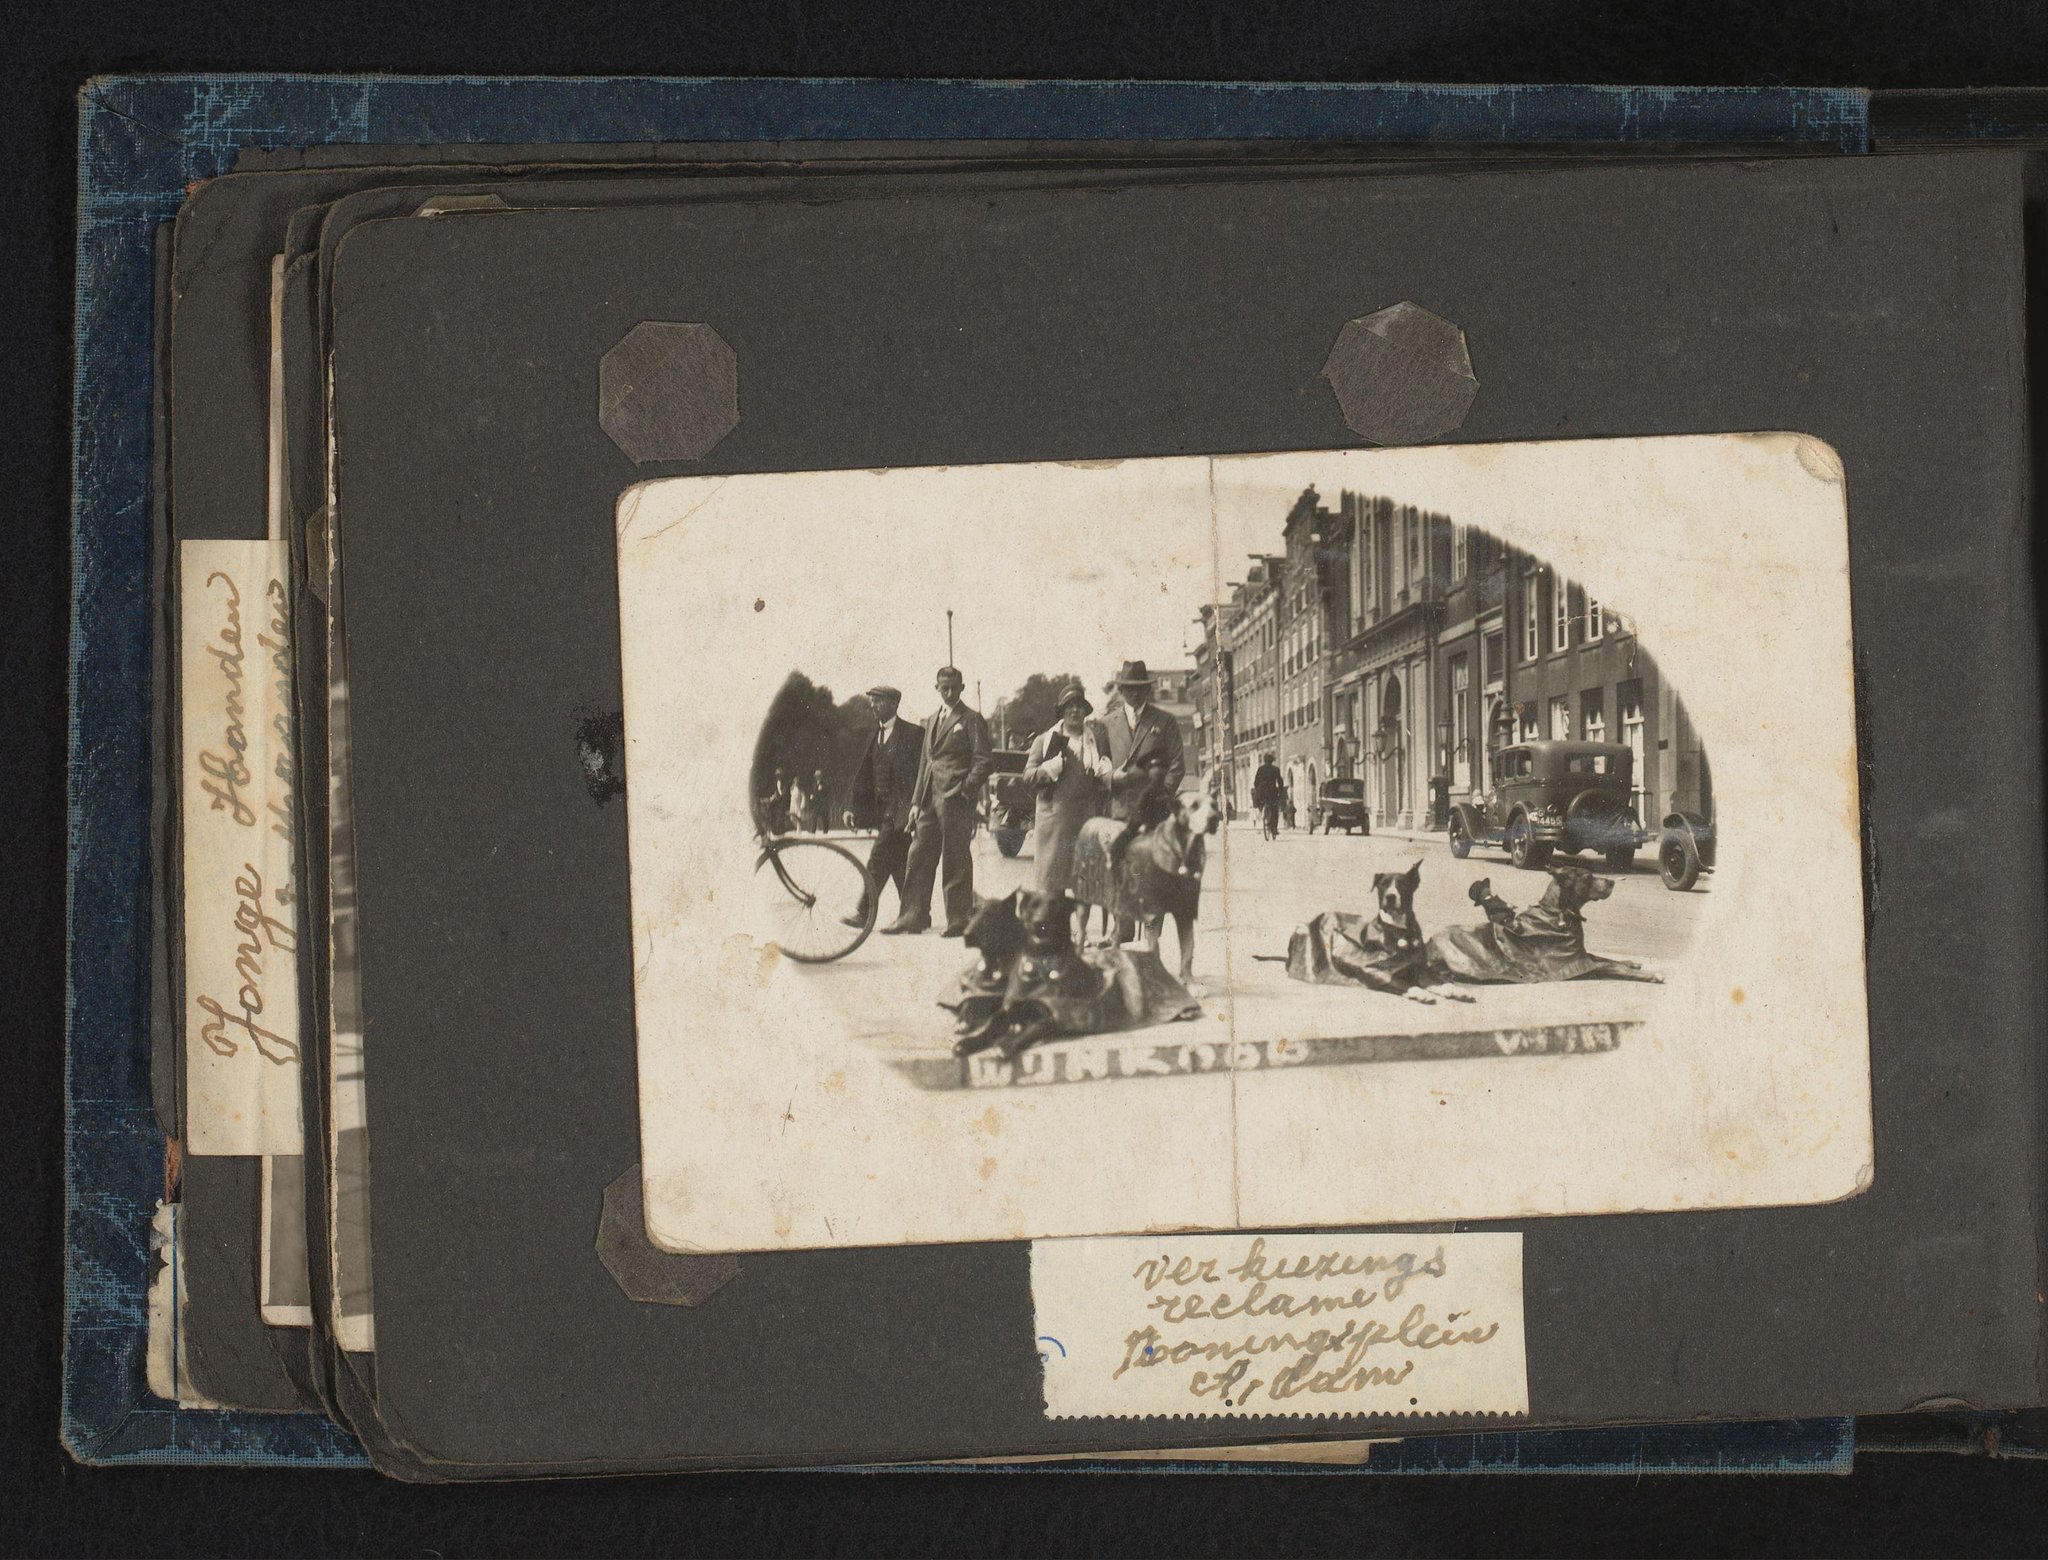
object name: album leaf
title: Honden met reclameteksten voor verkiezingen op het Koningsplein te Amsterdam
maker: Anonymous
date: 1930-1940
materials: photographic support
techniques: gelatin silver print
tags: advertising, street, dog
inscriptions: annotation: ‘verkiezings/ reclame/ Koningsplein/ A'dam’